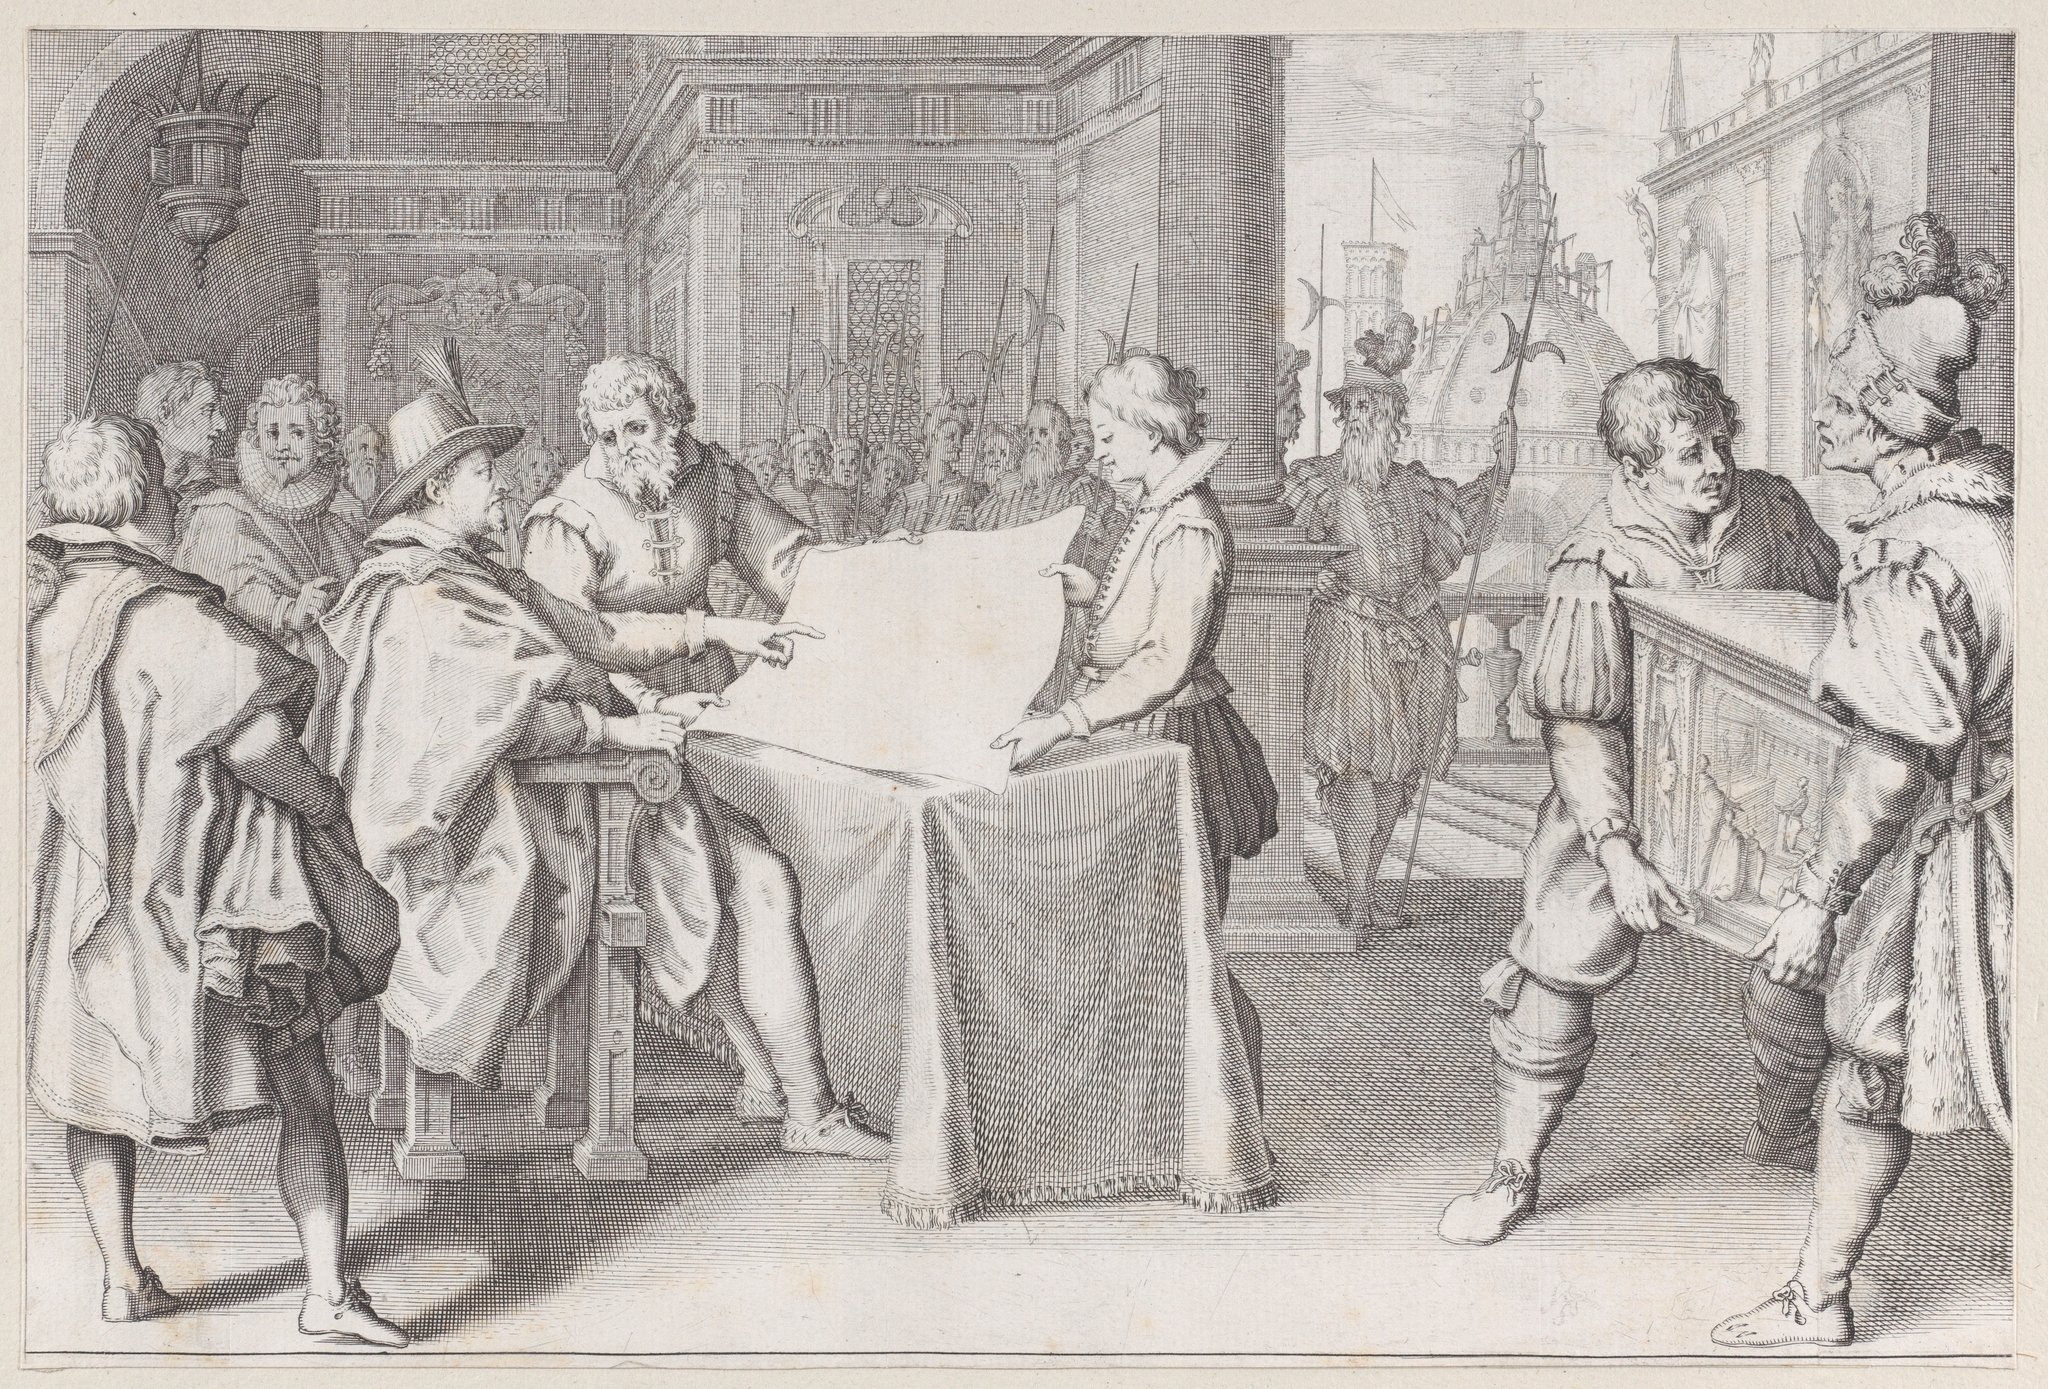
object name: print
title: Restauration du Dome de S. Maria del Fiore a Florence (The Restoration of the Dome of S. Maria del Fiore in Florence), from "La Vie de Ferdinand Ier de Médicis série appelée aussi Les Batailles des Médicis" (The Life of Ferdinand I de'Medici also called The Medici Battles)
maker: jacques callot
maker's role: artist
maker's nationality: french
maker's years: 1592-1635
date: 1614-1620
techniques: engraving